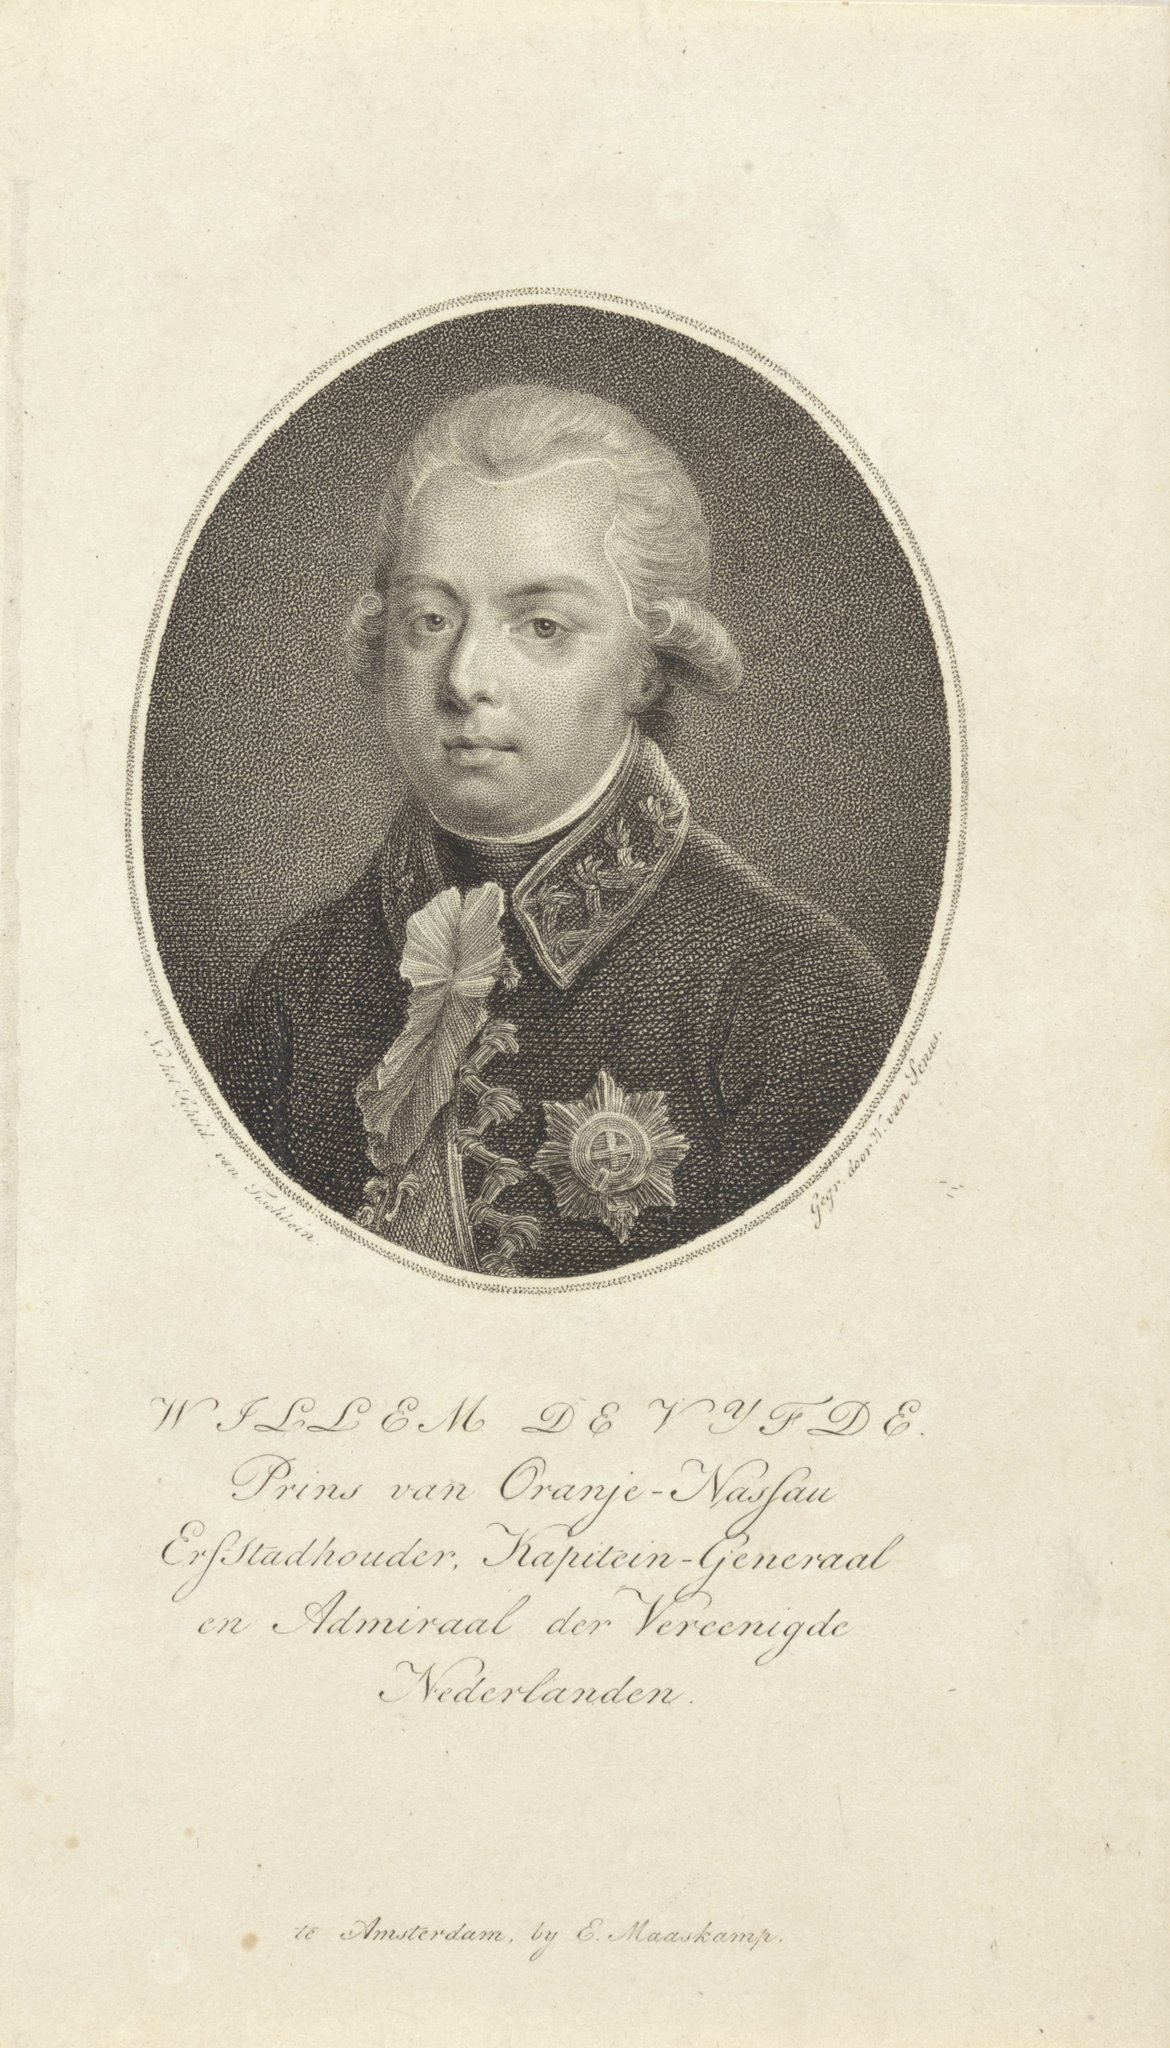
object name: print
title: Portret van Willem V (prins van Oranje-Nassau)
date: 1822-1826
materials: paper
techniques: engraving, etching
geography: amsterdam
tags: william v (prince of orange)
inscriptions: collector's mark: Lugt 2228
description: Prent gebruikt in: Stuart, Martinus. Vaderlandsche historie, vervattende de geschiedenissen der Vereenigde Nederlanden, van de vestiging van het Erfstadhouderschap in de mannelijke en vrouwelijke linie, tot aan 's Lands verlossing, uit de inlijving in het Fransche Keizerrijk. Amsterdam: Evert Maaskamp, 1822-1826.